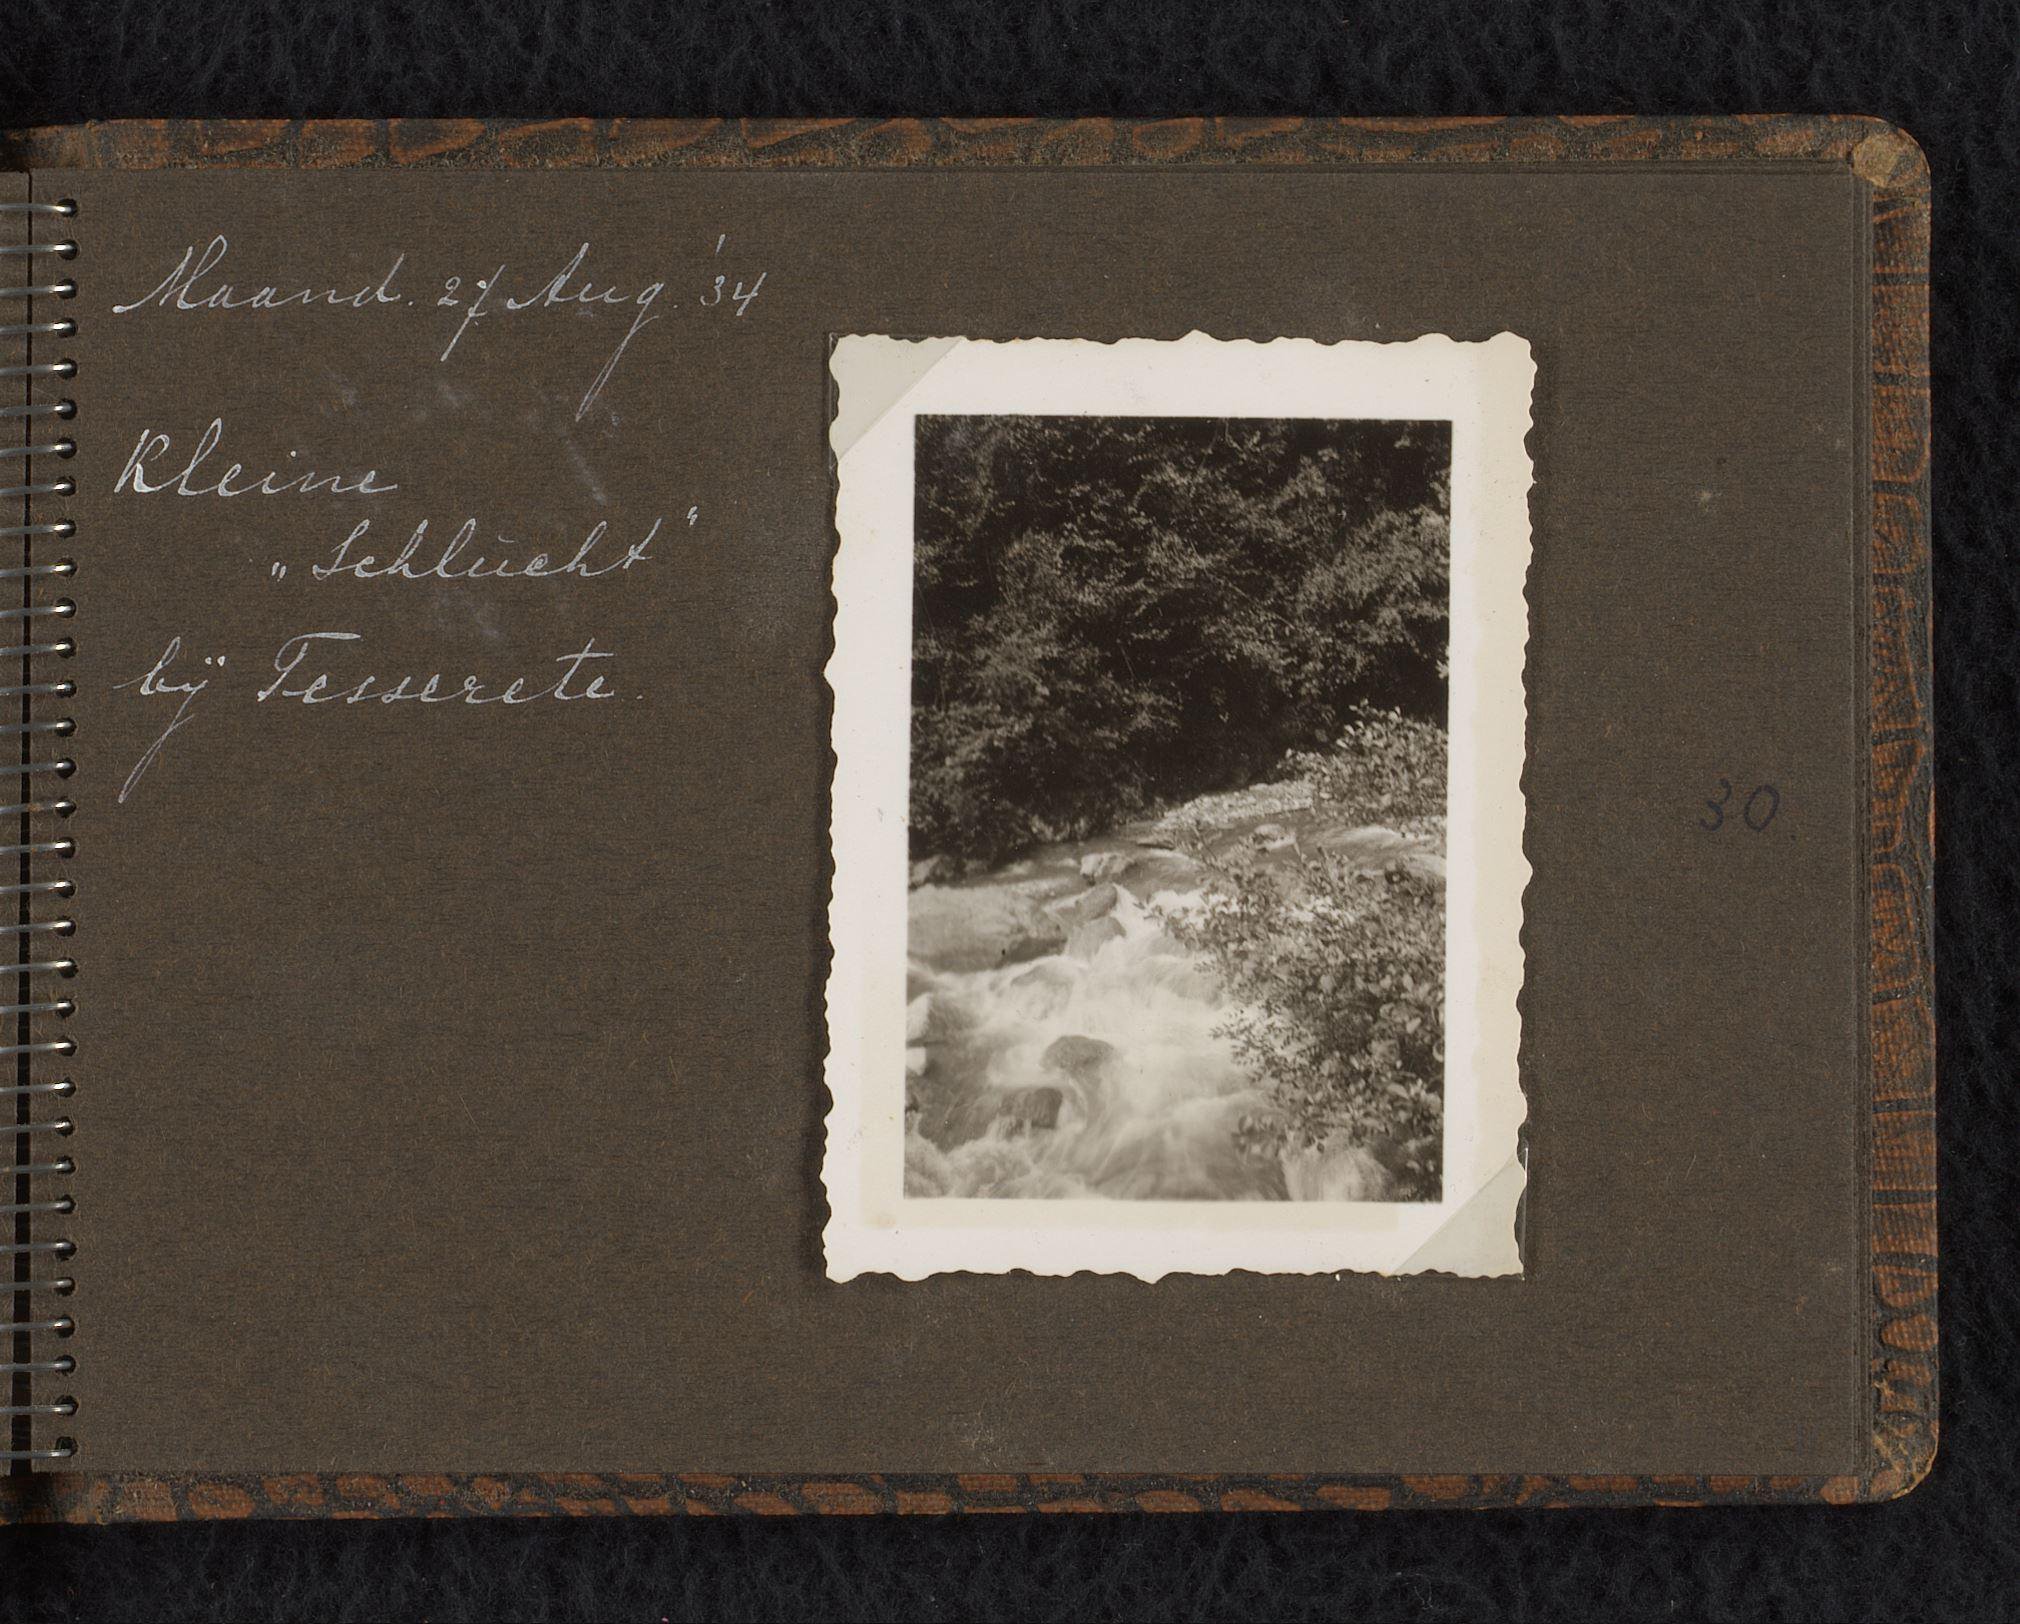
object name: photograph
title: Kleine "Schlücht" bij Tesserete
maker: Anonymous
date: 1934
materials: paper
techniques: gelatin silver print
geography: tesserete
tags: brook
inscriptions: number: ‘30’